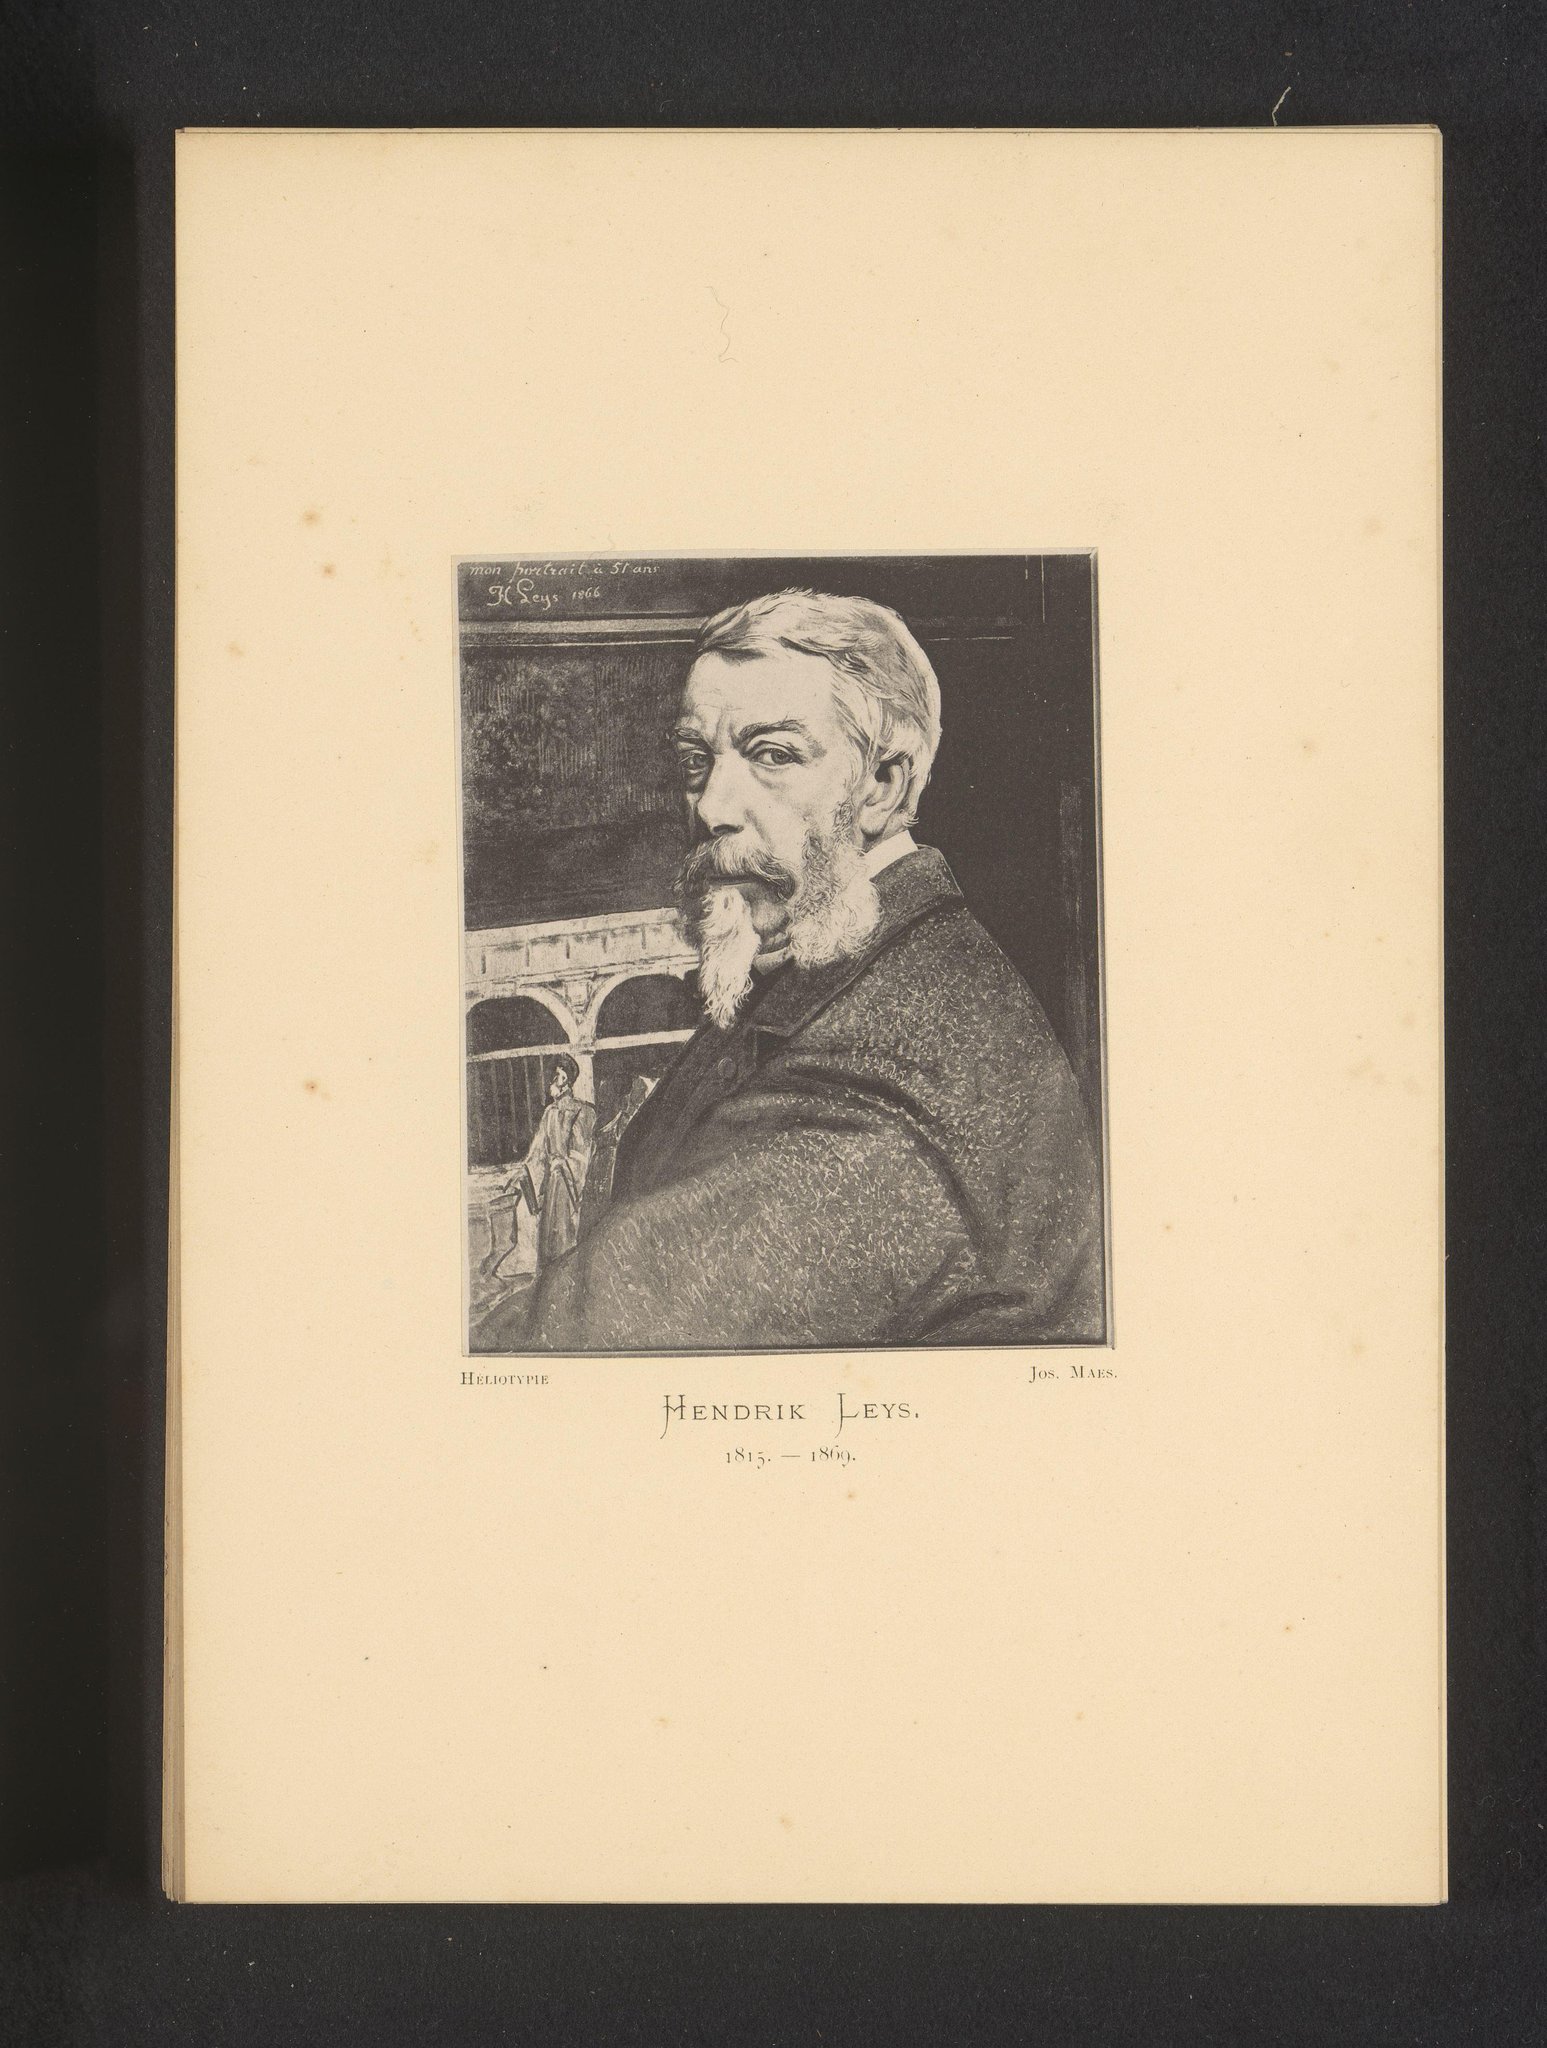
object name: reproduction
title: Hendrik Leys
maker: joseph maes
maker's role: fotograaf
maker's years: 1838-1908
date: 1872-1877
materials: cardboard, paper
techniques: photograph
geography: antwerp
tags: antwerp, painter, print maker, draughtsman, henri leys (baron), historical persons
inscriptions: inscription: ‘1815. - 1869.’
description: Deze prent maakt deel uit van een omslag met 150 prenten en een katern met een lijst van afbeeldingen.